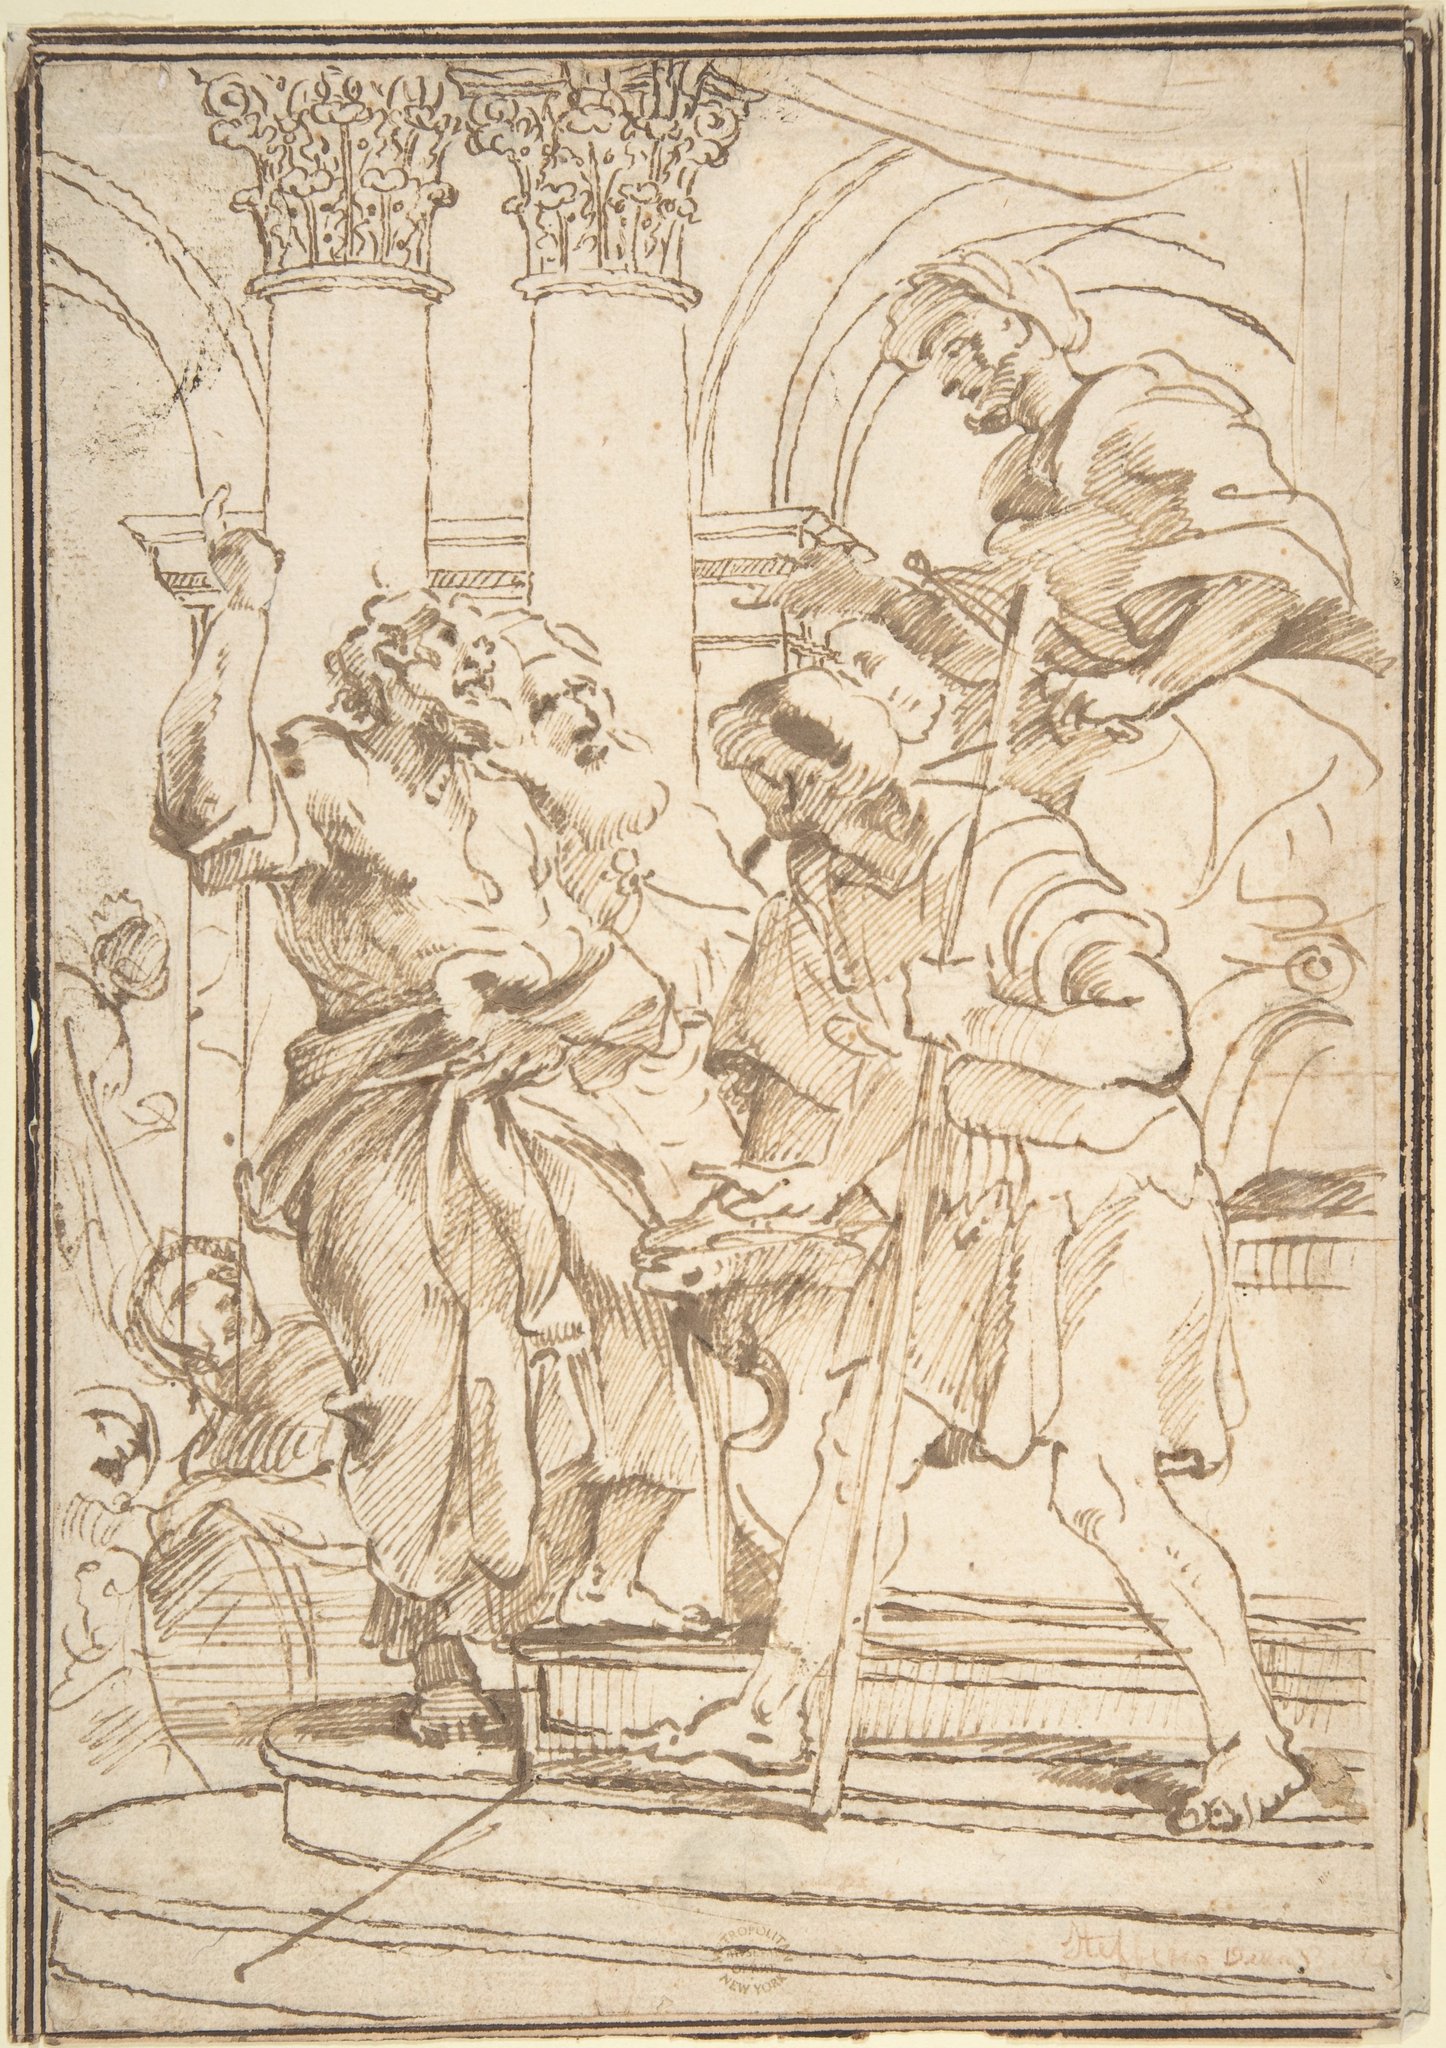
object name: drawing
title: Figures in a Temple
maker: anonymous, italian, roman-bolognese, 17th century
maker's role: artist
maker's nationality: italian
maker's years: 1600-1700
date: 1601-1700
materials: chalk, ink, paper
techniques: pen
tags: men